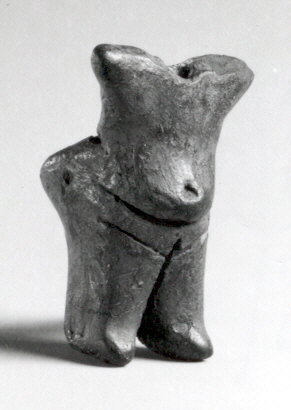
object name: sculpture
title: Standing female (with a hole for attachment of the head, now missing)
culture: hacilar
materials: ceramic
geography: southwestern anatolia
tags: women